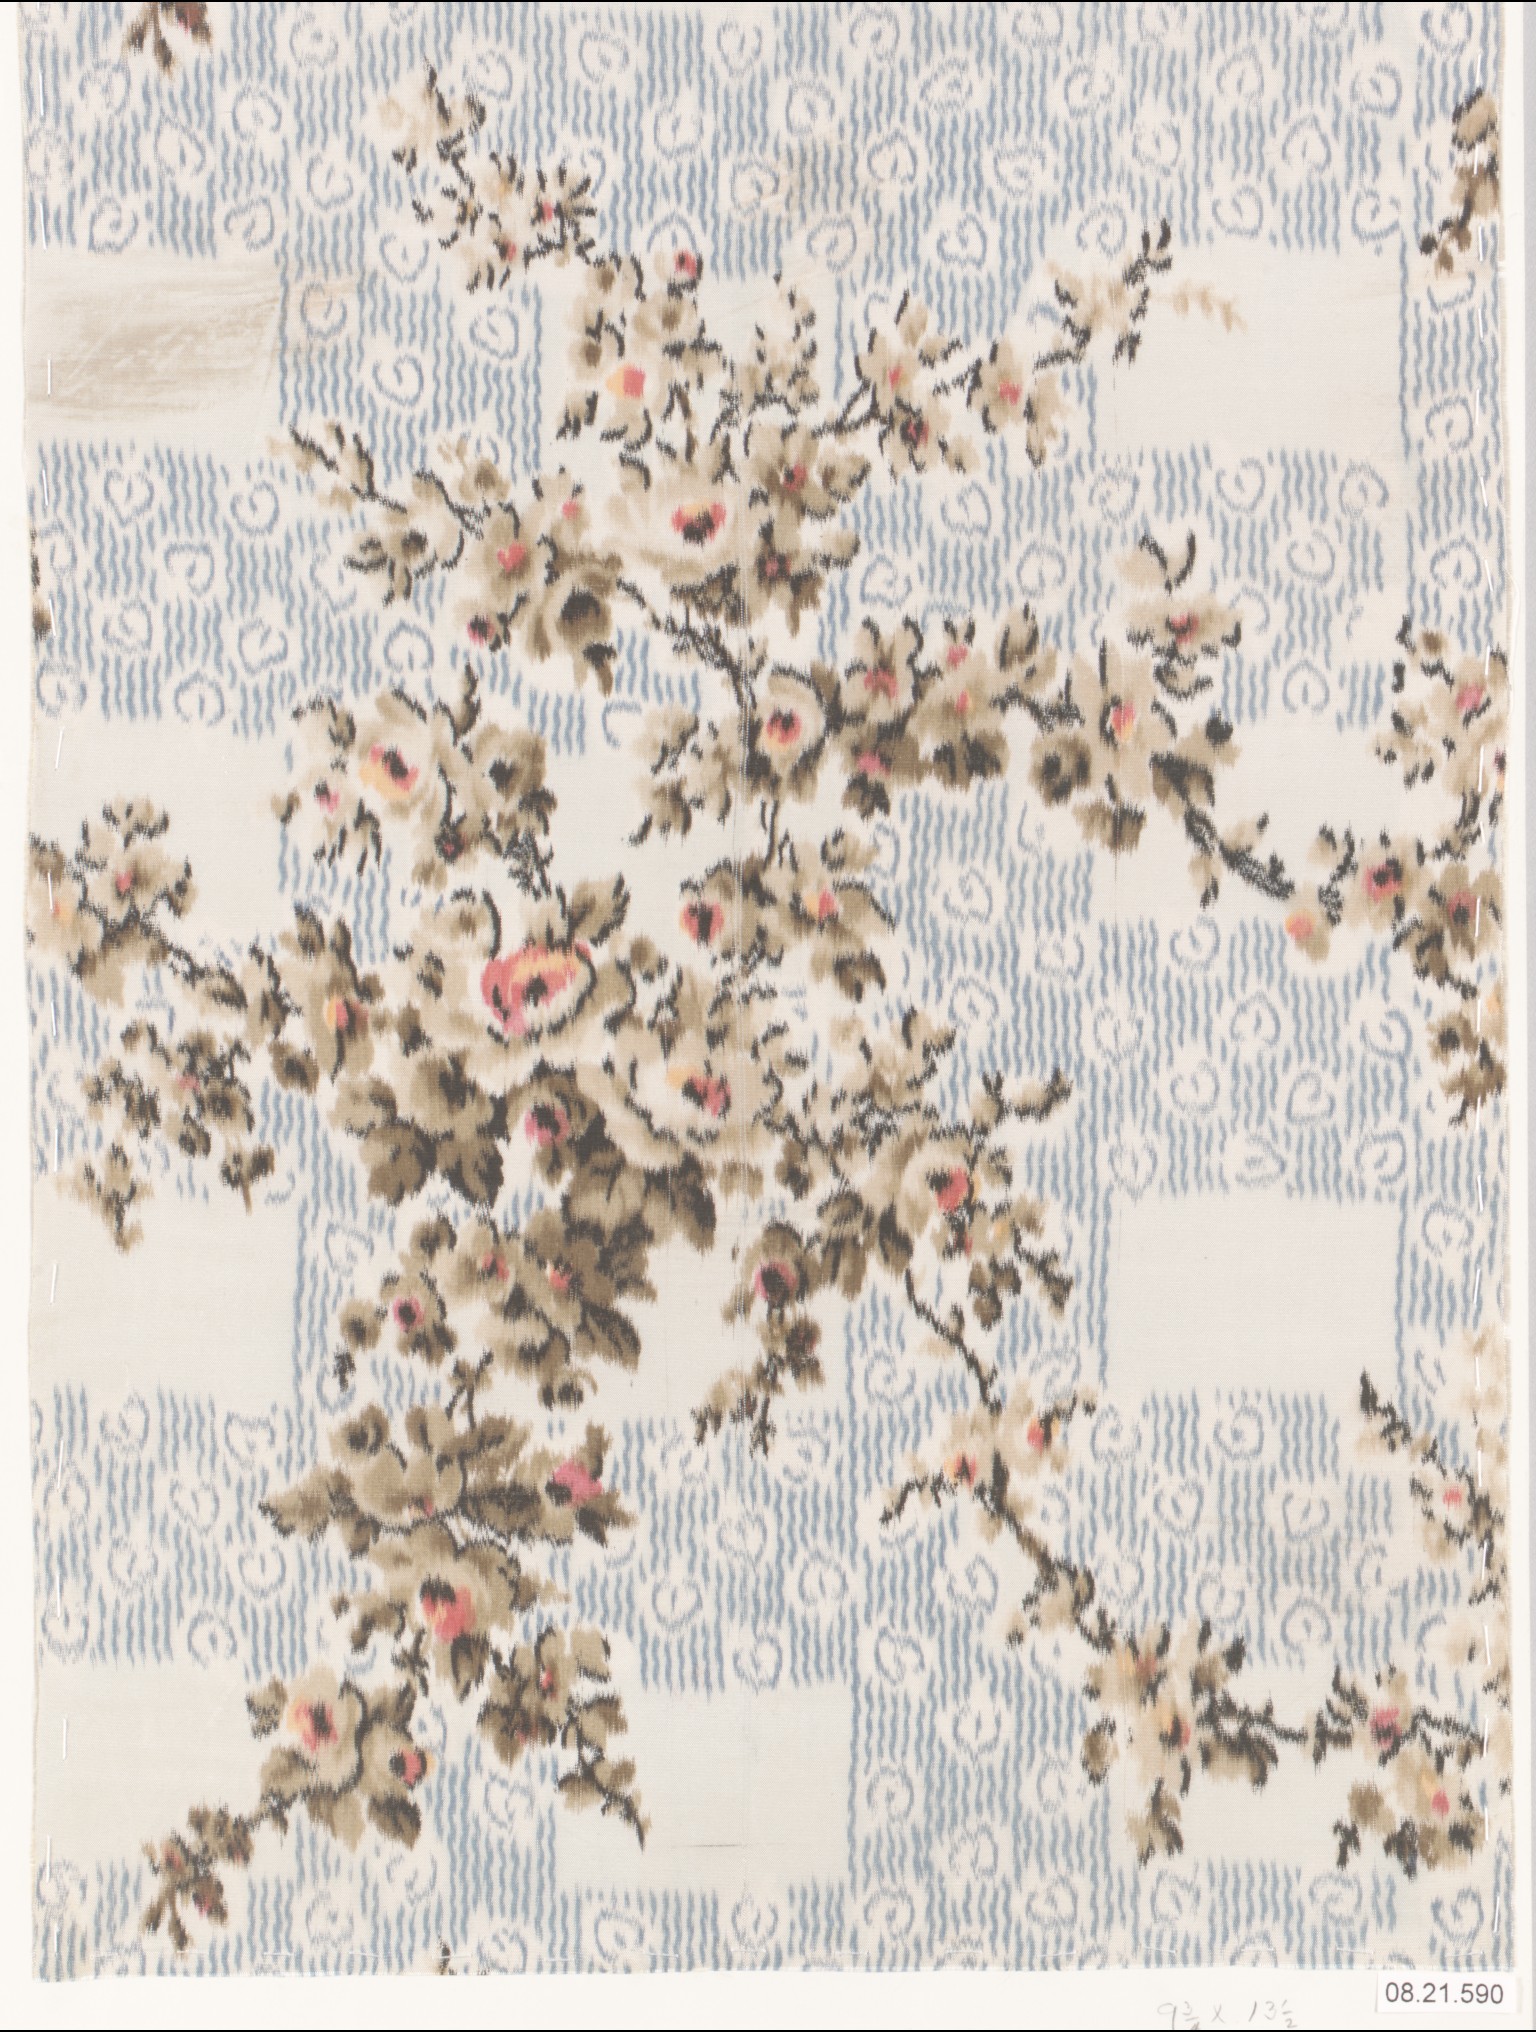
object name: textile sample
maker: Anonymous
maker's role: designer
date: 1900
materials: silk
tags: flowers